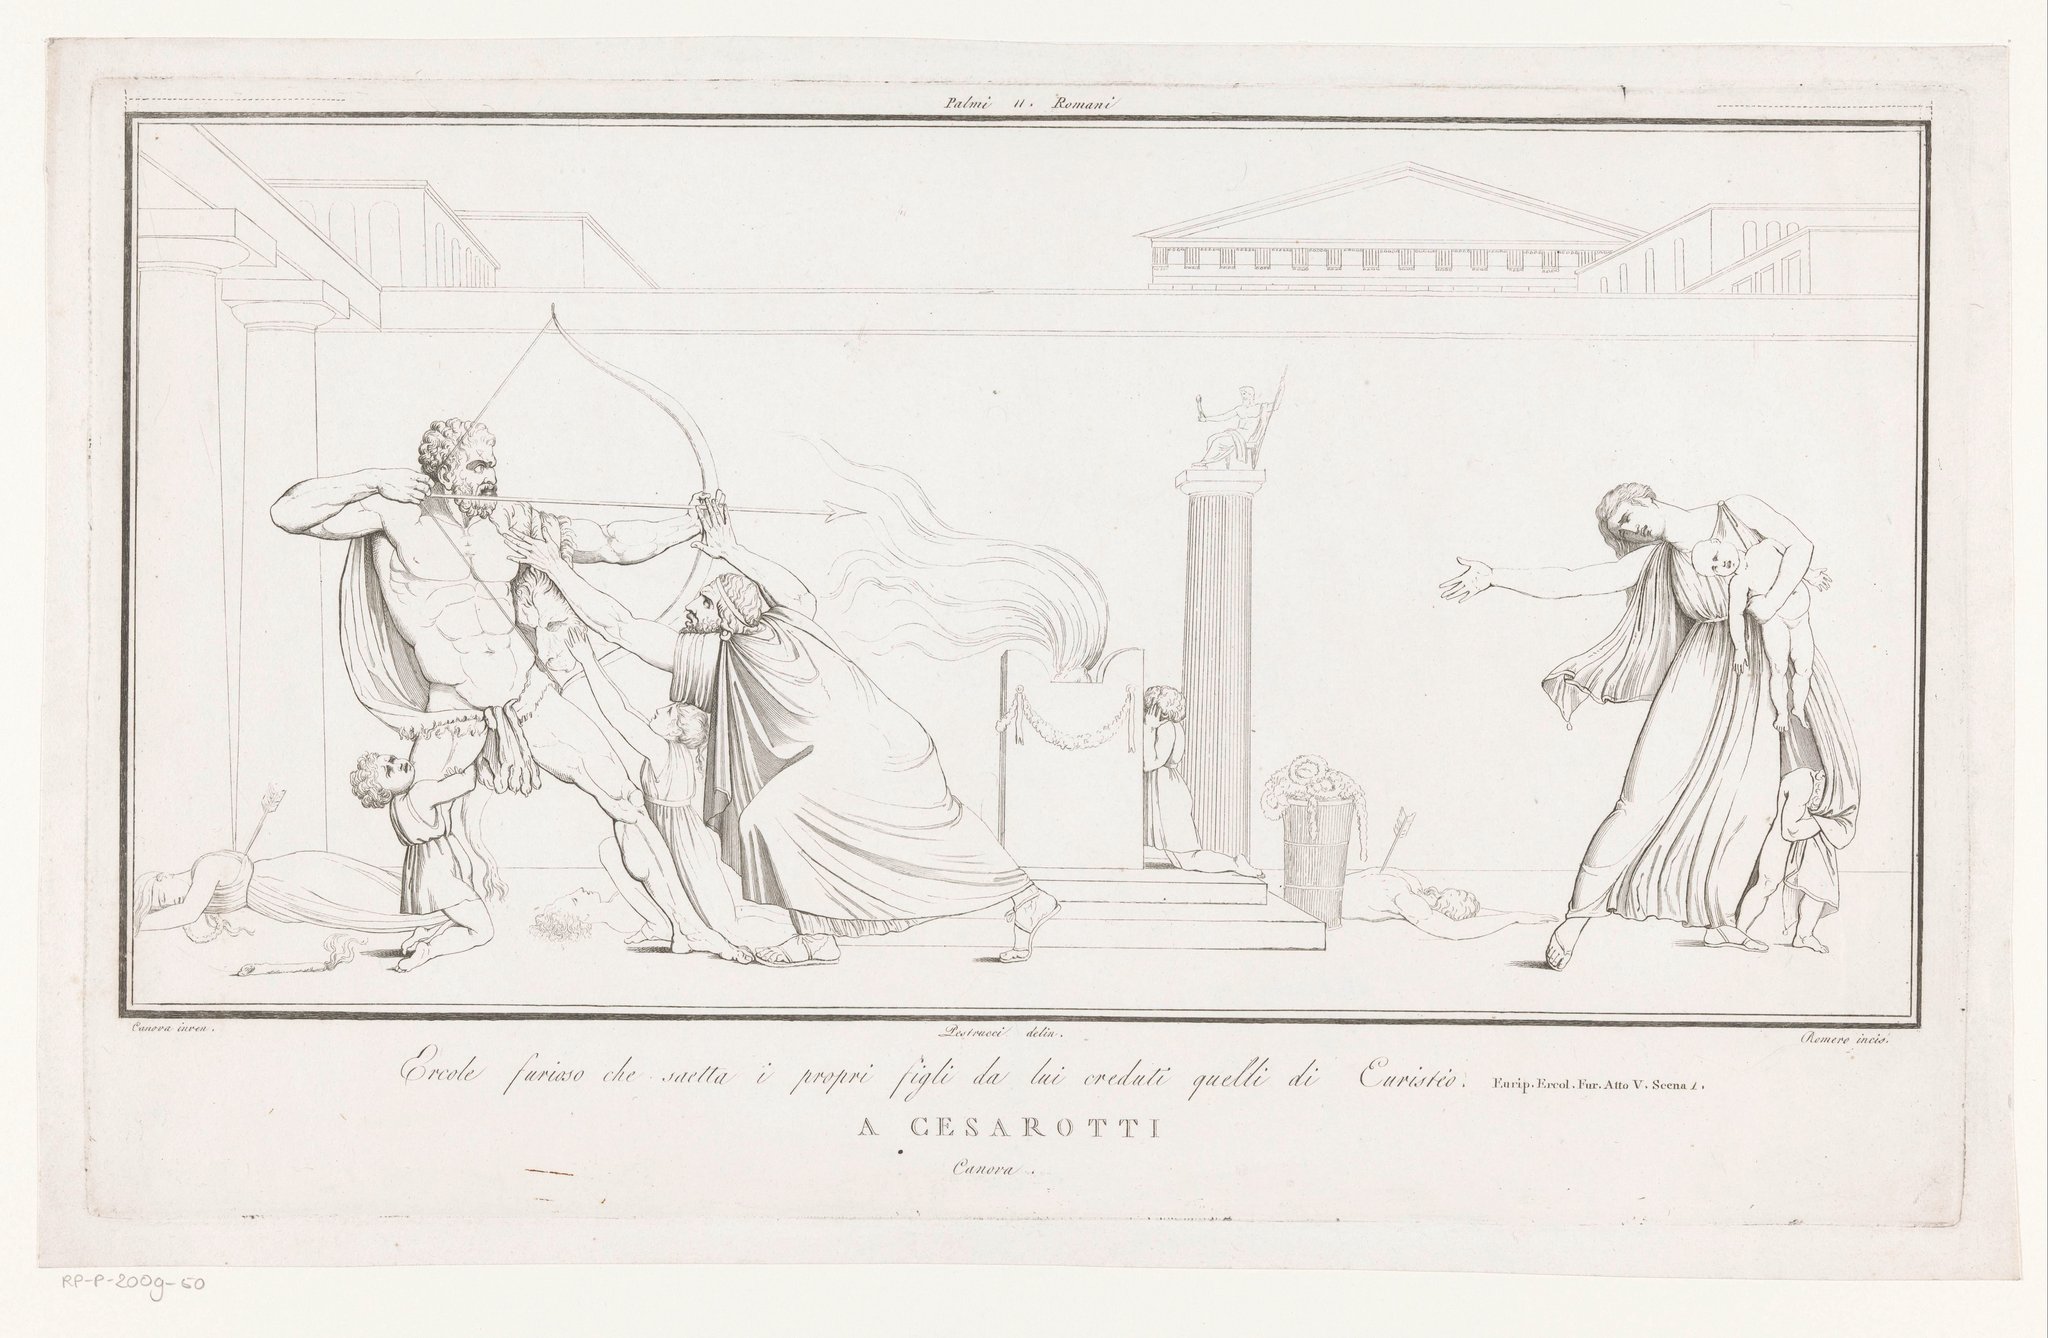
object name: print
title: De woedende Hercules schiet een pijl af op Iole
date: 1766-1802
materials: paper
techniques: etching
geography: italy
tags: eurytus and his sons are beaten by hercules in a shooting contest, of which the prize was iole, the king's daughter; but eurytus refuses to give her to hercules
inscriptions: collector's mark: Lugt 2228, collector's mark: Lugt 2760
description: Hercules richt een pijl op Iole, de dochter van de Myceense koning Eurystheus. Nadat Hercules een schietwedstrijd had gewonnen van de zonen van Eurystheus zou zijn prijs Iole zijn. Maar Eurystheus weigert zijn dochter af te staan. Tekst in het Italiaans in ondermarge.